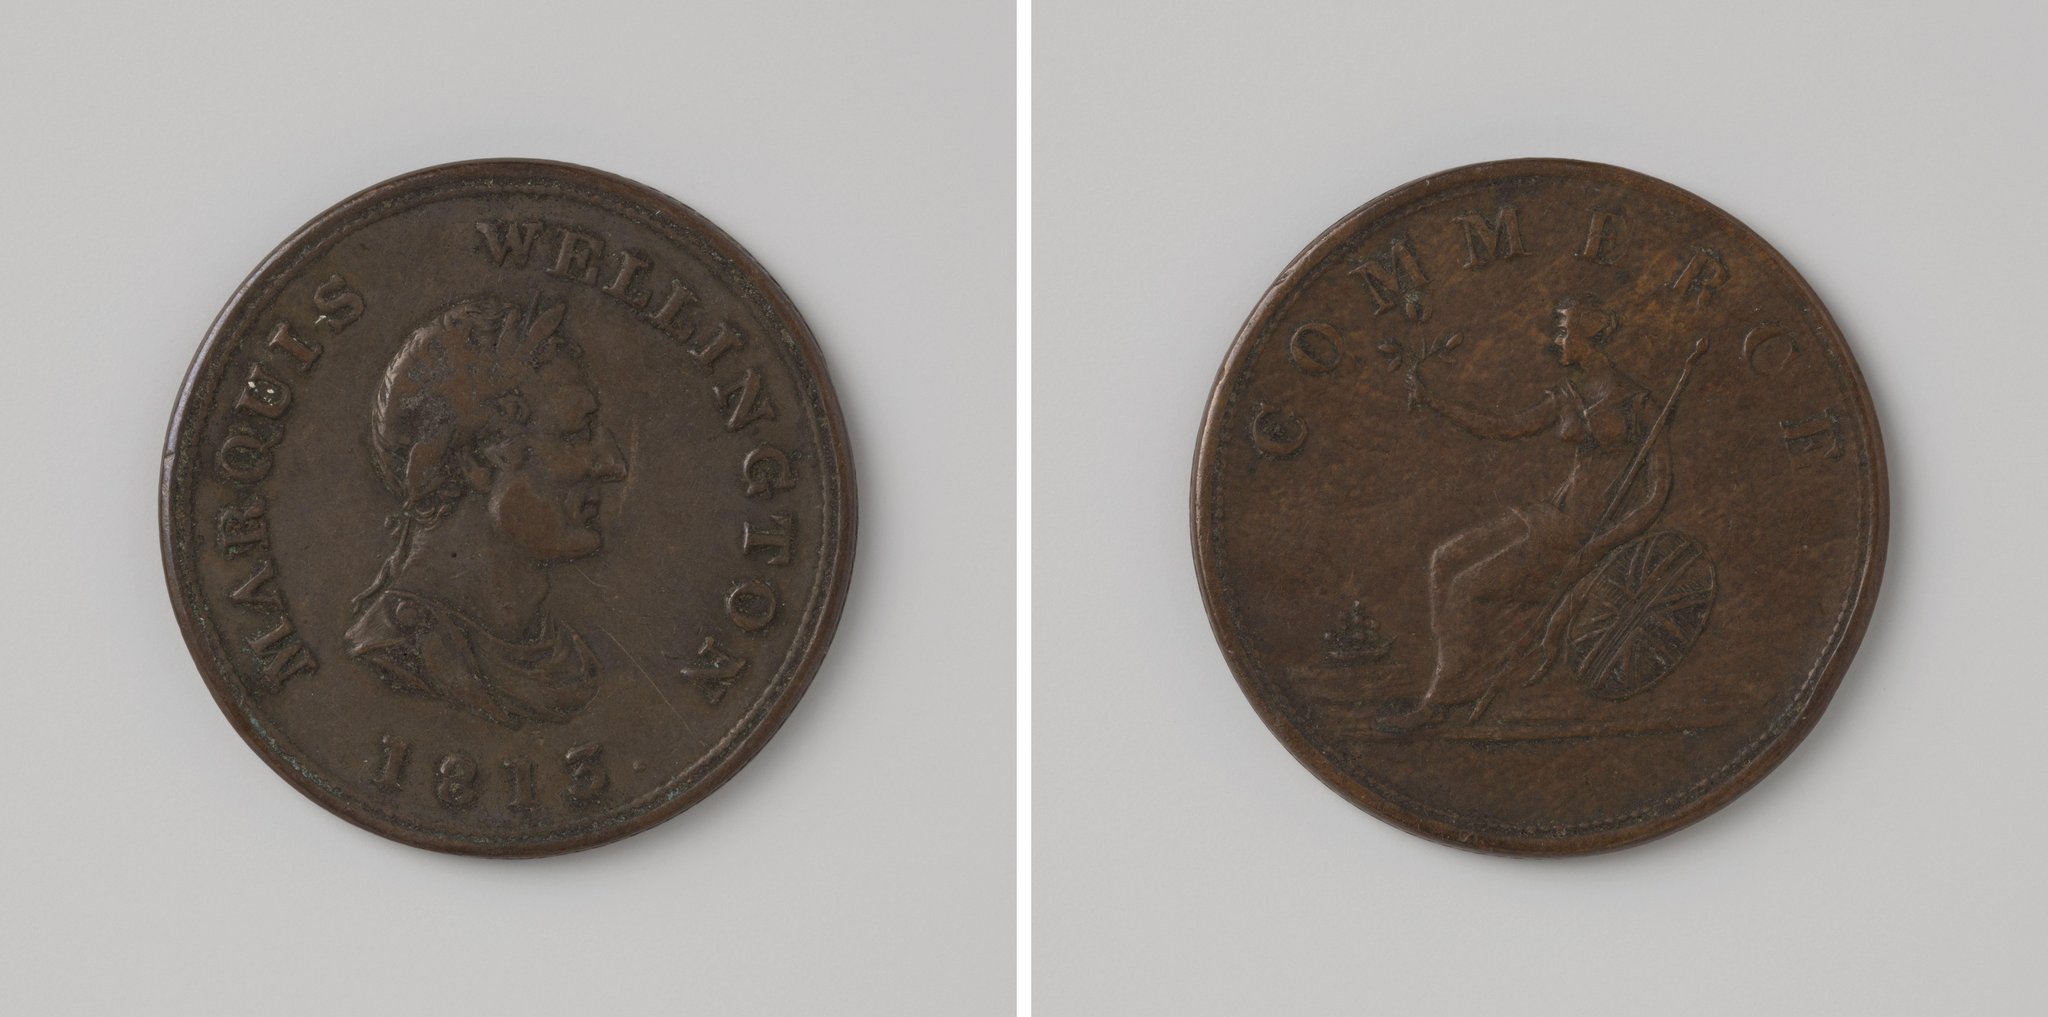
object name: history medal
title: Hertog van Wellington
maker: Anonymous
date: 1813-1815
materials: copper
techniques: striking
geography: england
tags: walmer castle, arthur wellesley of wellington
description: Koperen penning. Voorzijde: borststuk man met lauwerkrans binnen omschrift. Keerzijde: Britannia met schild, speer en roos; op achtergrond schip op zee binnen omschrift